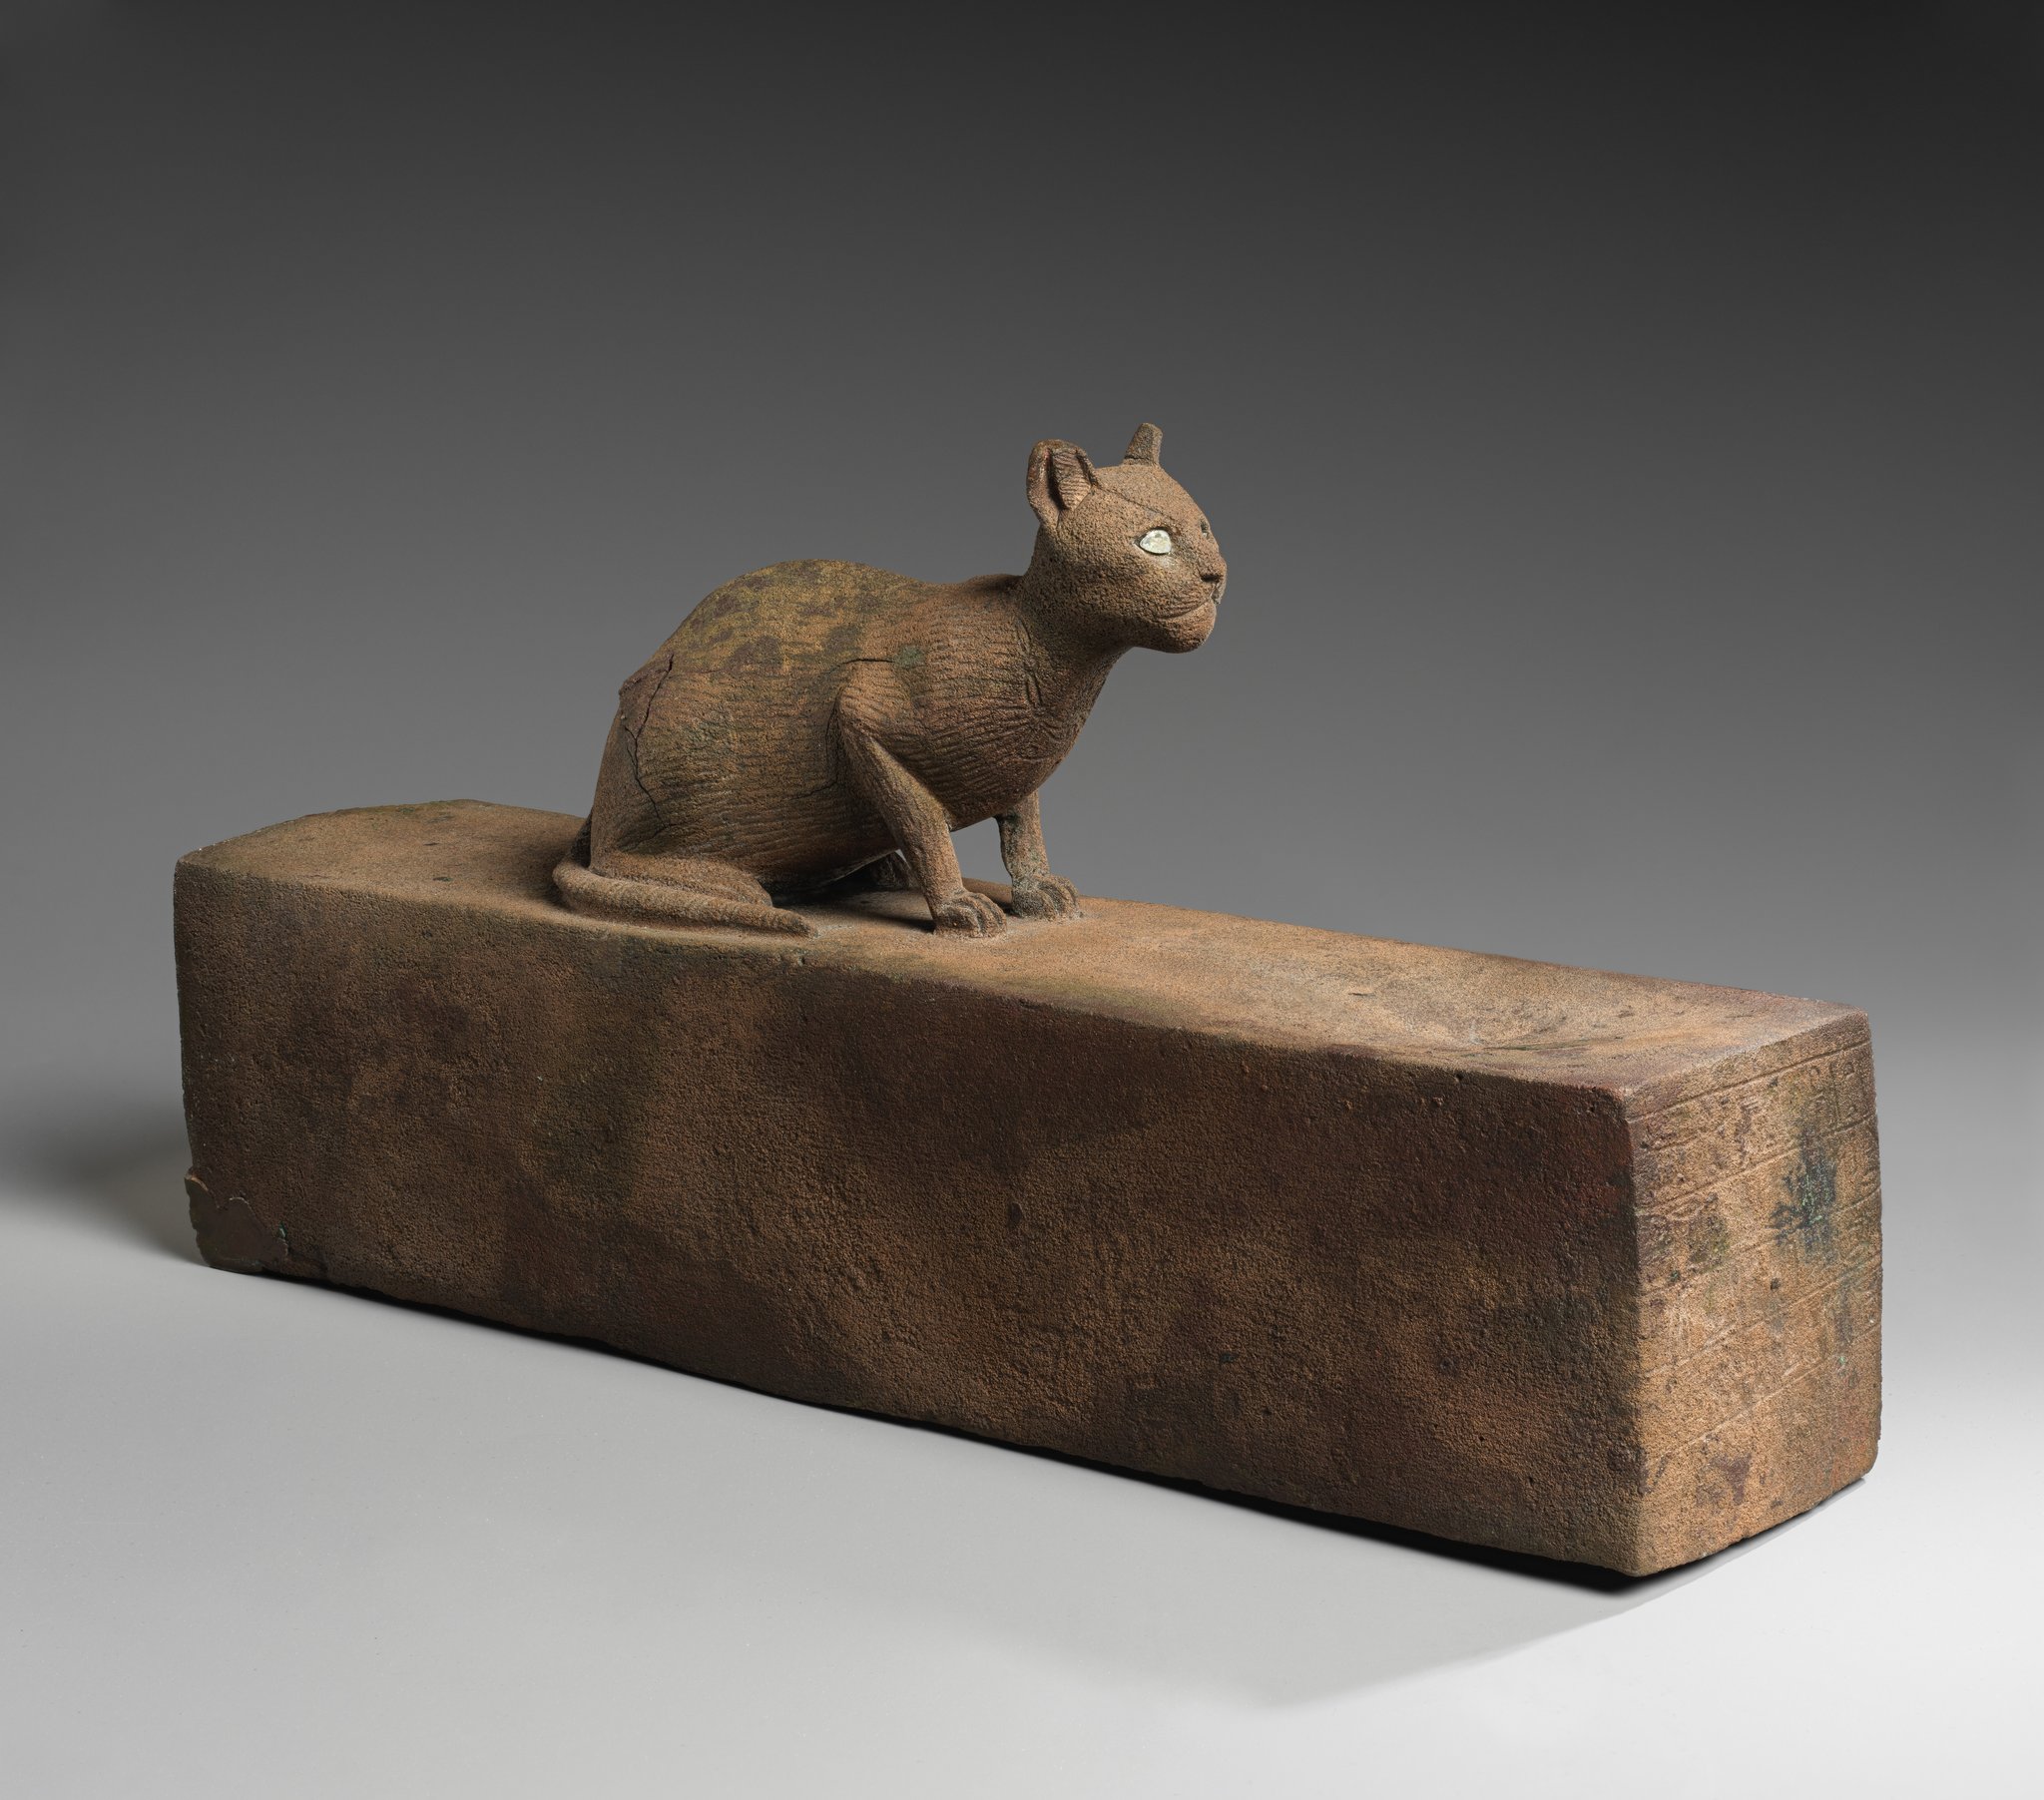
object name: mummy case, cat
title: Box for a cat mummy inscribed for Bastet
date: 664-630 BCE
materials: metal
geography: egypt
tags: cats